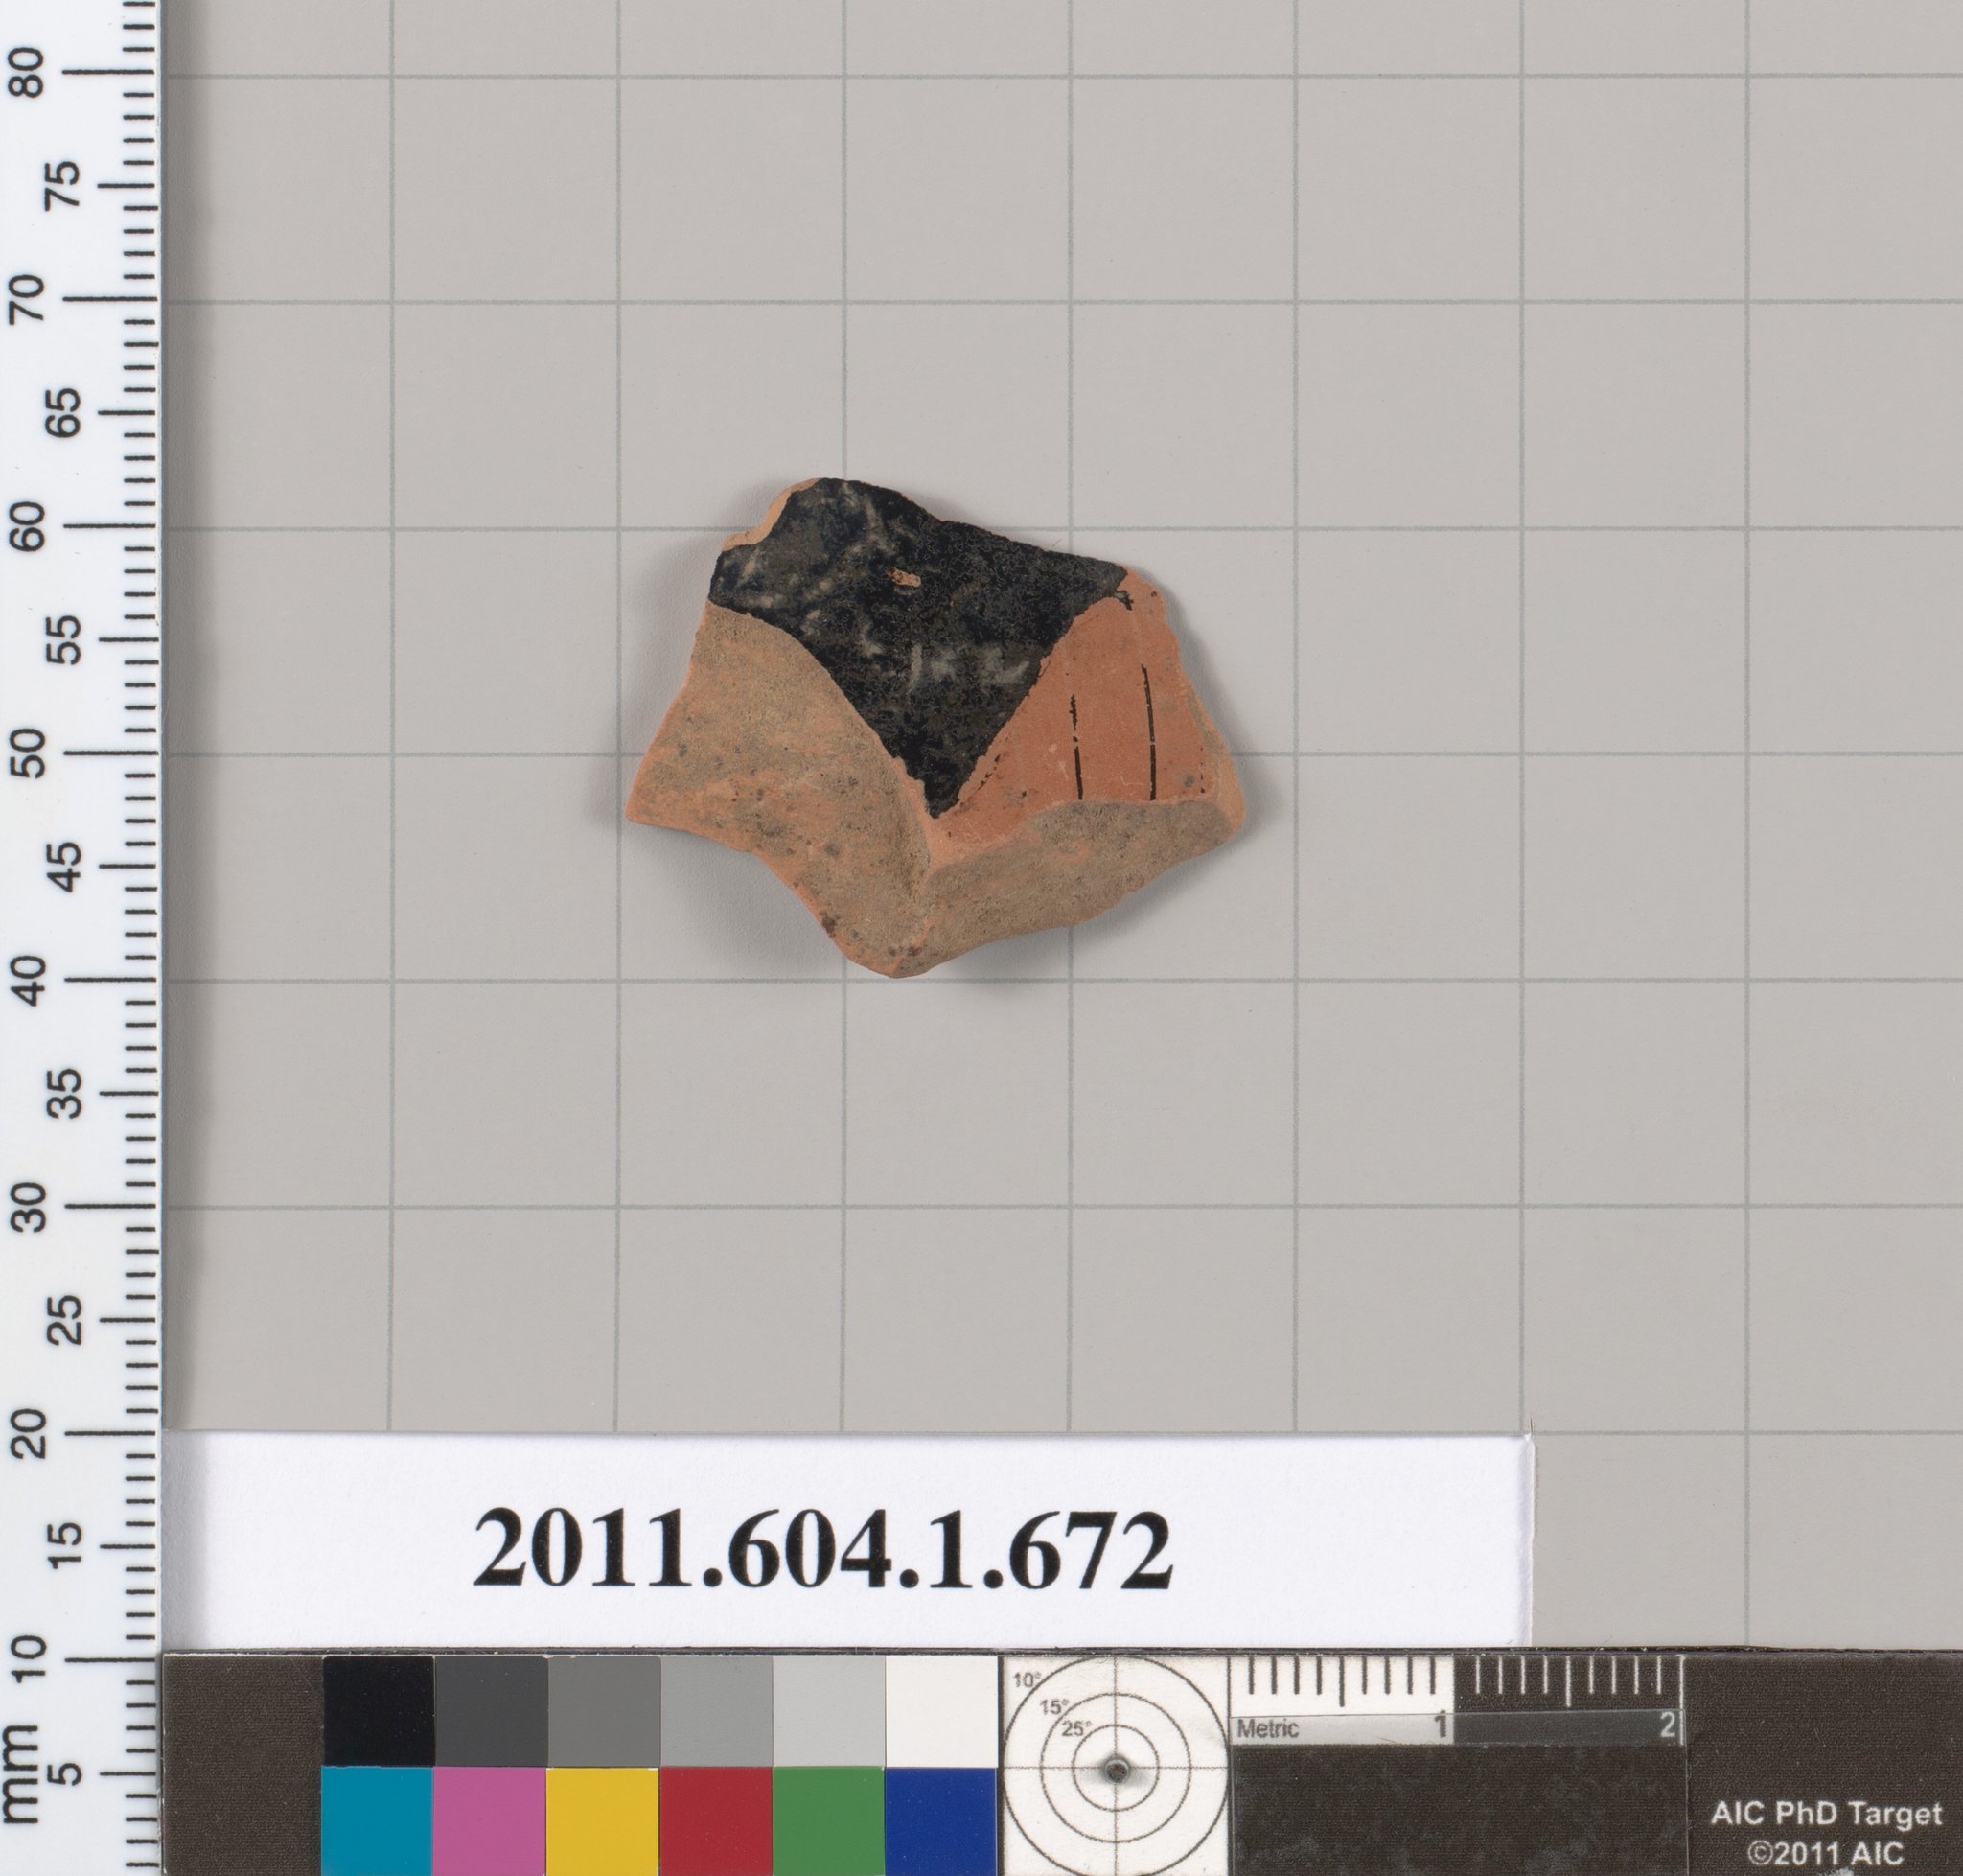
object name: kylix fragment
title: Terracotta fragment of a kylix (drinking cup)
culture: greek, attic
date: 475-451 BCE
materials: terracotta